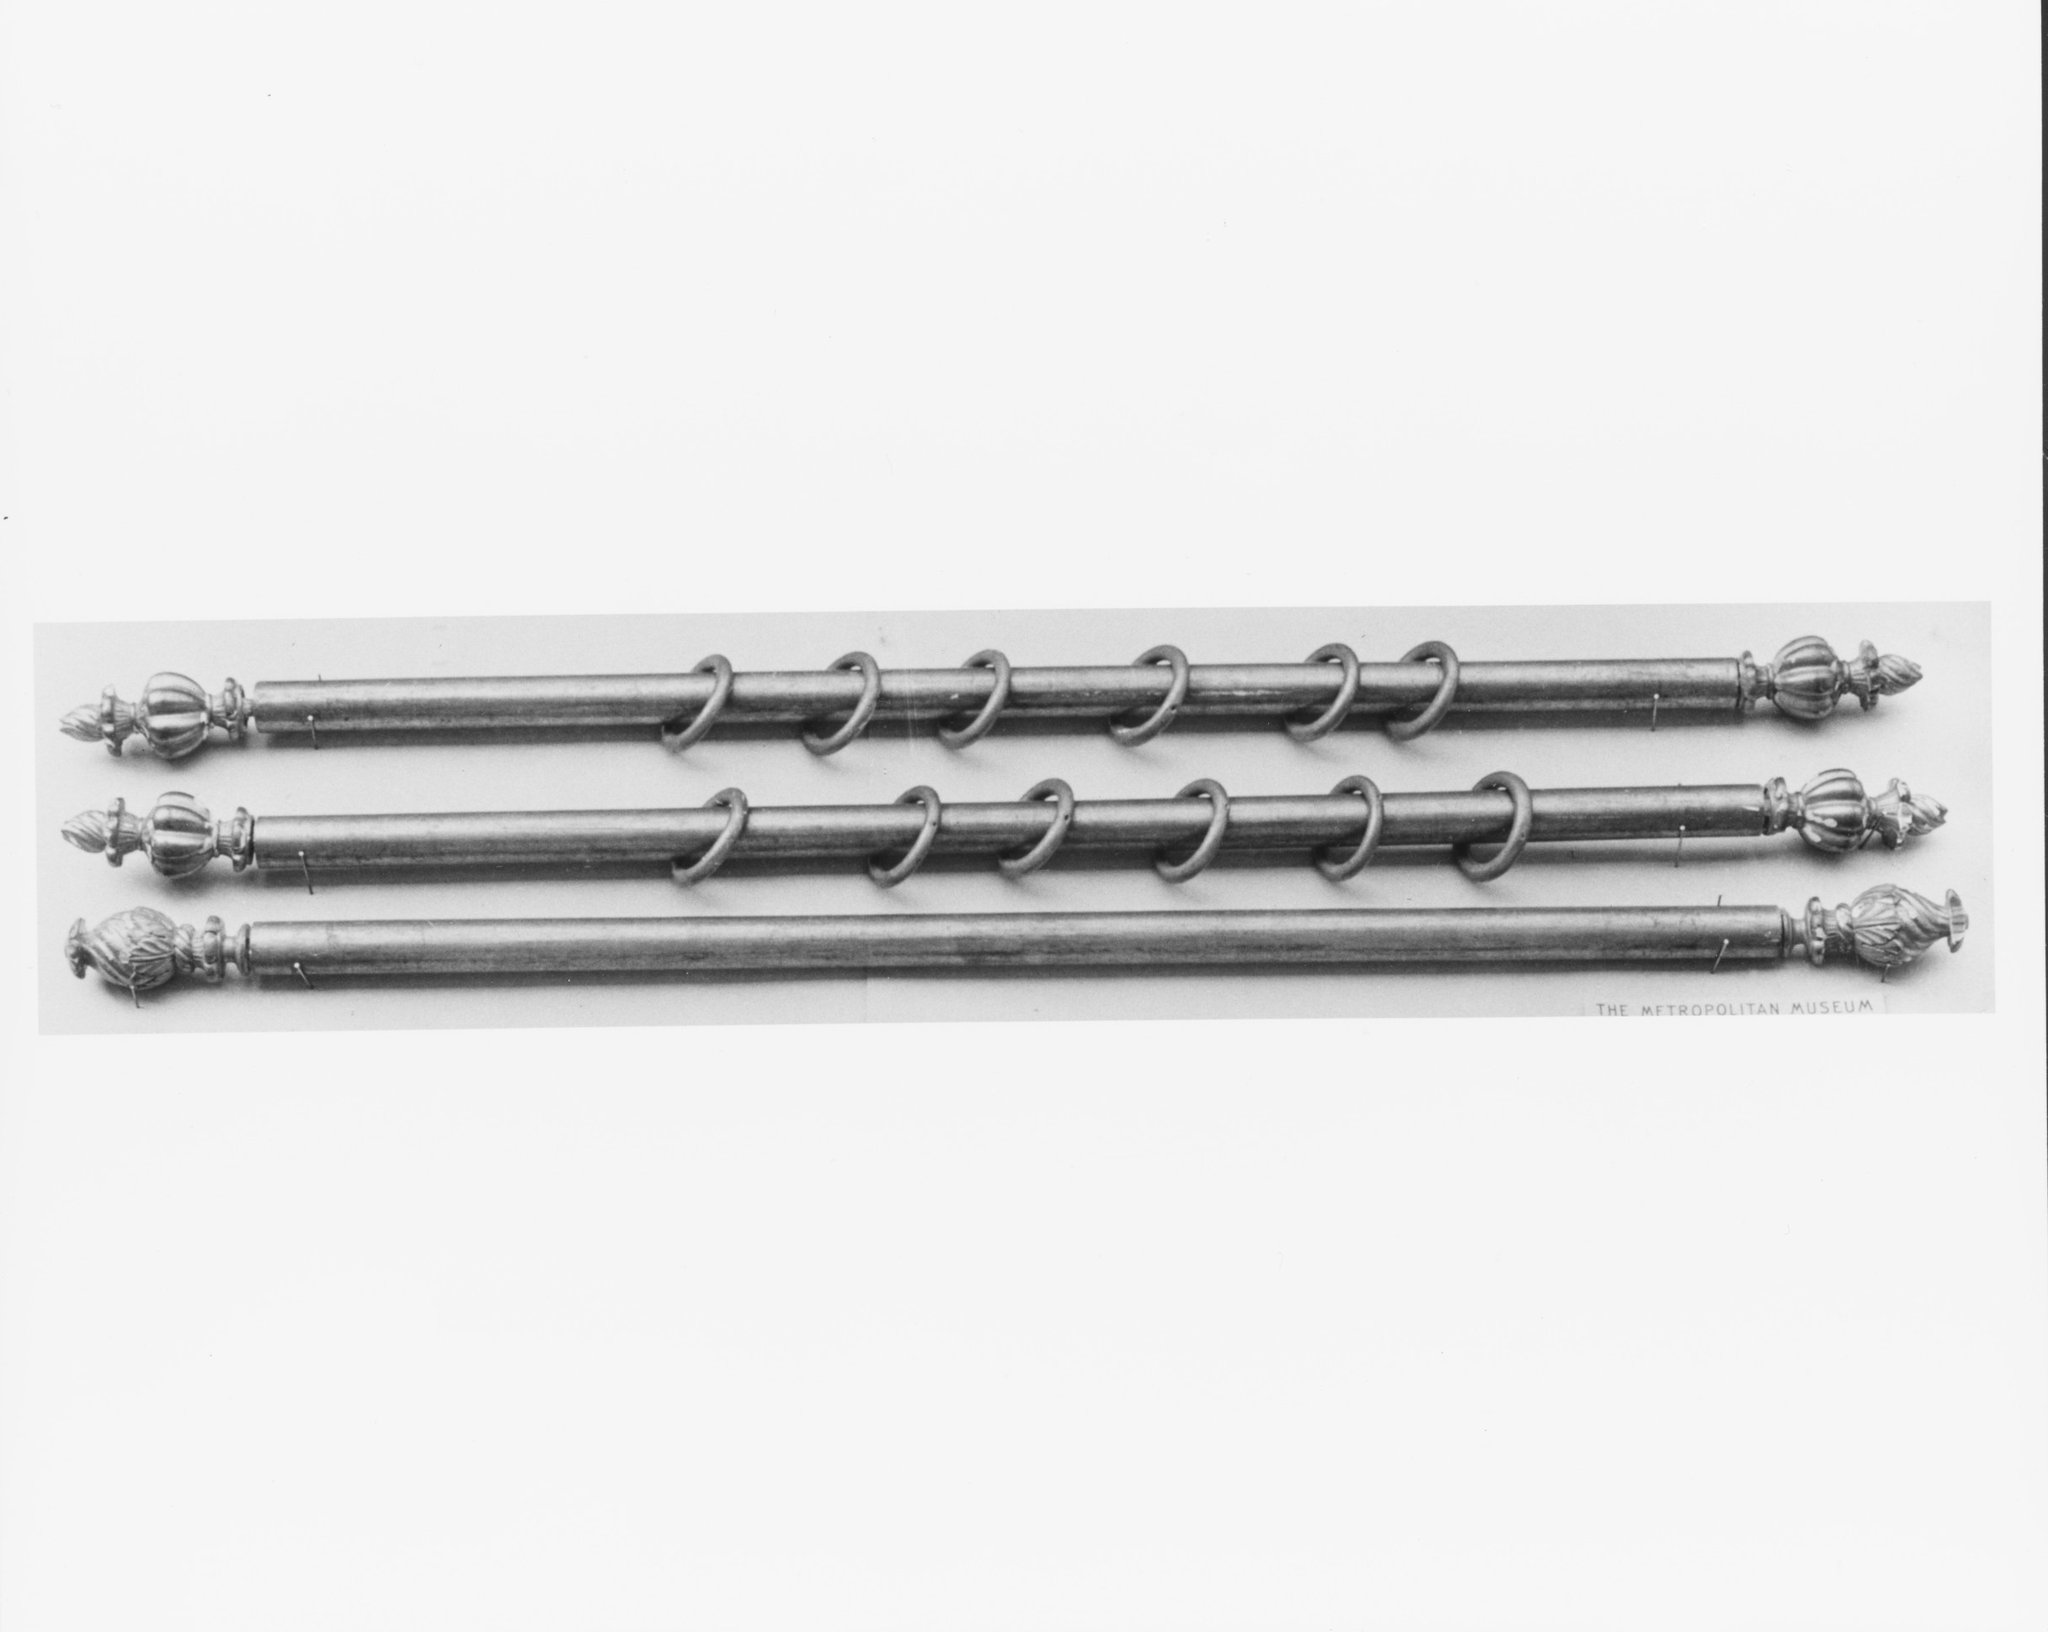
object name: curtain pole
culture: american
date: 1770-1800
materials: plaster, wood